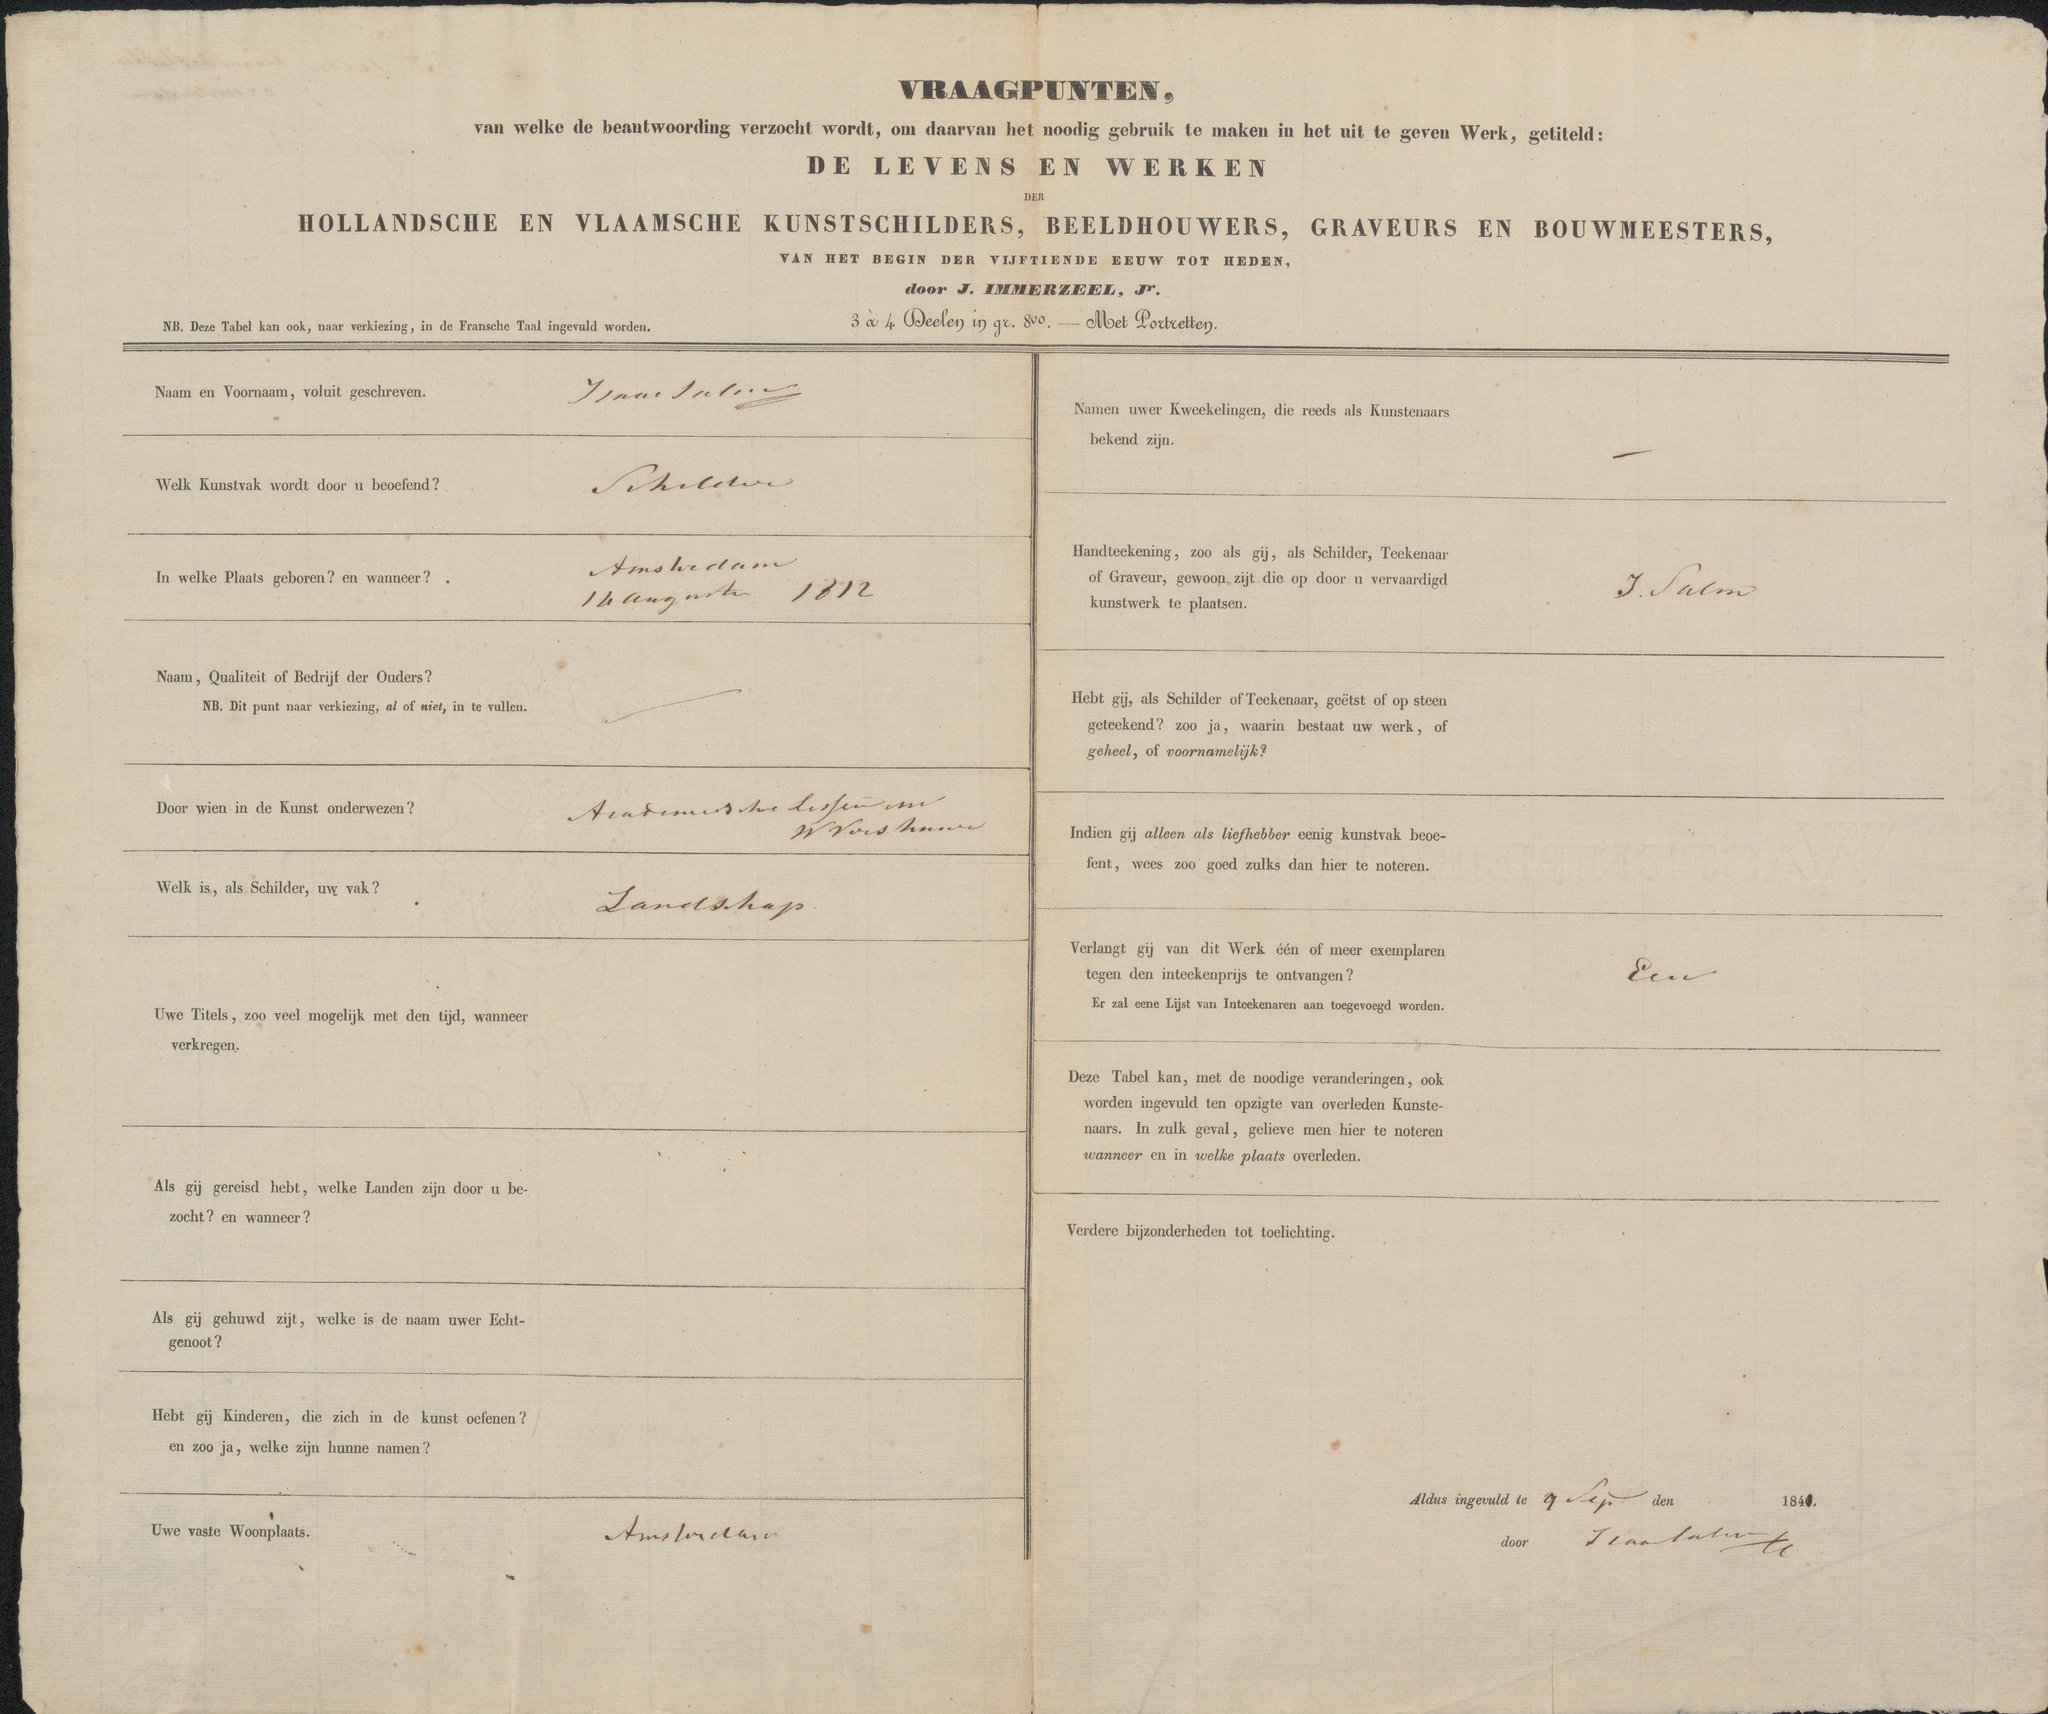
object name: manuscript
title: Enquêteformulier ingevuld door Isaac Salm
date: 1841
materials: ink, paper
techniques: pen, printing, writing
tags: amsterdam, draughtsman, isaac salm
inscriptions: inscription: ‘Vraagpunten,/ van welke de beantwoording verzocht wordt, om daarvan het noodig gebruik te maken in het uit te geven Werk, getiteld: De levens en werken/ der Hollandsche en Vlaamsche kunstschilders, beeldhouwers,/ graveurs en bouwmeesters, van het begin der vijftiende eeuw tot heden/ door J. Immerzeel, Jr.’, watermark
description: Opgenomen in: Immerzeel, J. Jr., De levens en werken der Hollandsche en Vlaamsche kunstschilders, beeldhouwers, graveurs en bouwmeesters, van het begin der vijftiende eeuw tot heden, Amsterdam: J.C. van Kesteren, 1842-1843.